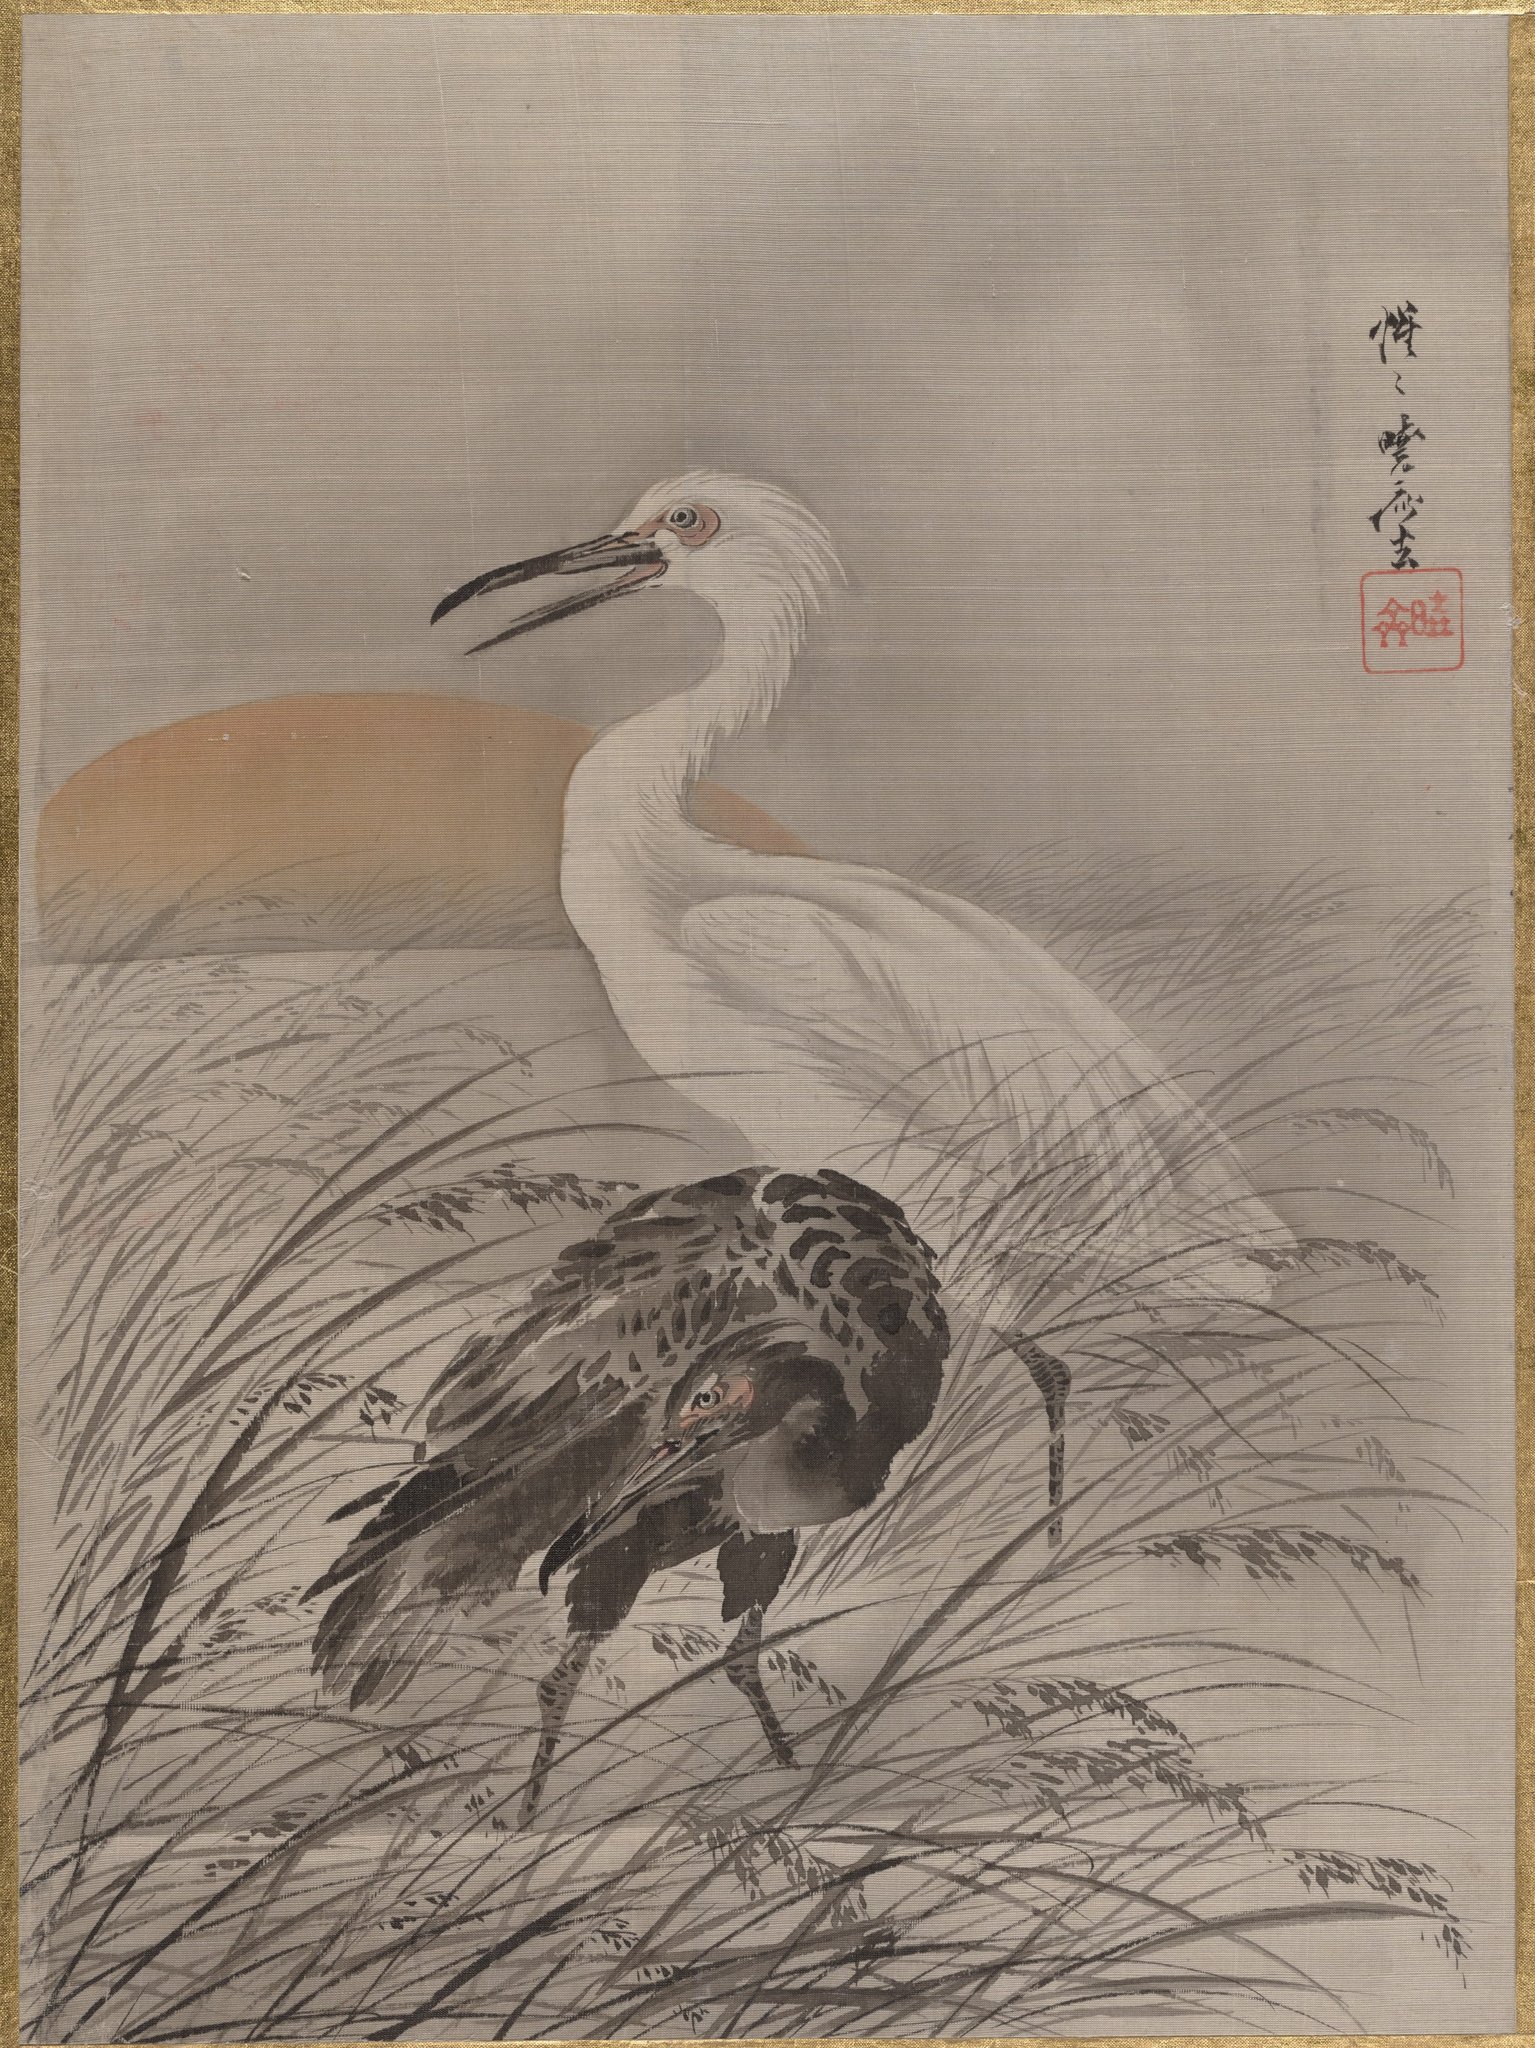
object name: album leaf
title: Cranes in Marsh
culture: japanese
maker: kawanabe kyōsai 河鍋暁斎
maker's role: artist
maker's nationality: japanese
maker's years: 1831-1889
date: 1887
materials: ink, silk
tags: cranes